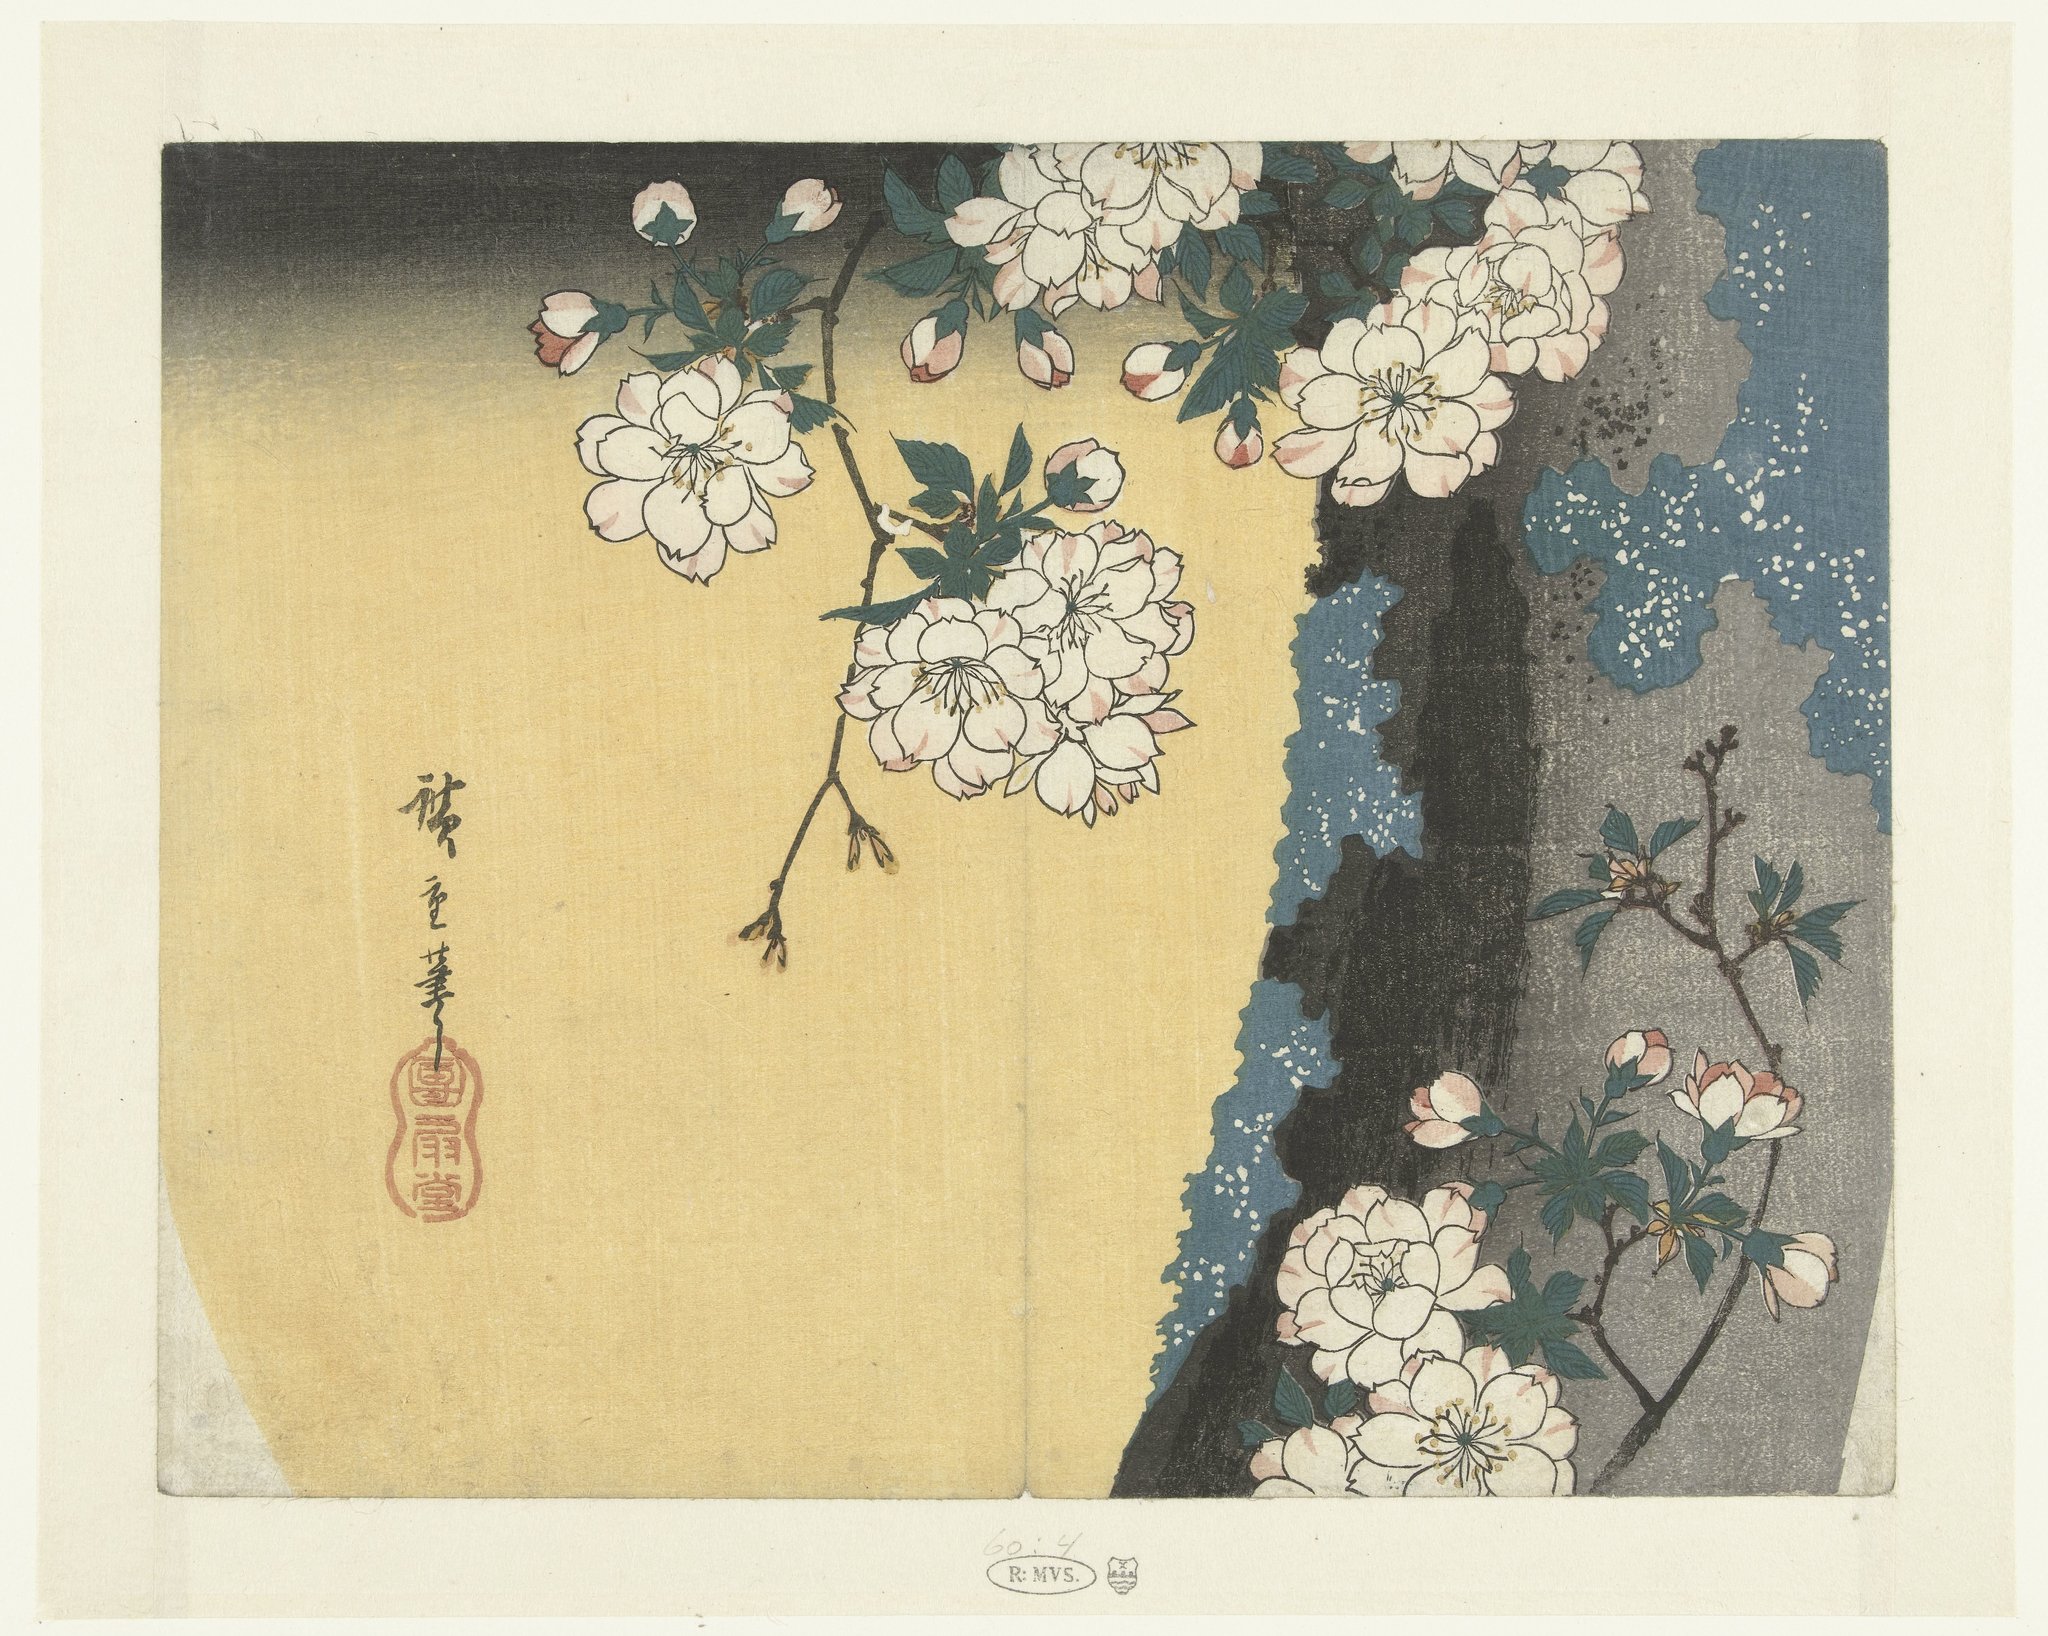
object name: uchiwa e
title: Mossy Trunk and Cherry Blossoms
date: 1833-1837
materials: paper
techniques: woodcut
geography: japan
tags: flowers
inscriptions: collector's mark: Lugt 2760, collector's mark: Lugt 2228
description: Waaierprent waarop kersenbloesem afgebeeld bij een boomstam waarop mos; tegen een gele achtergrond.